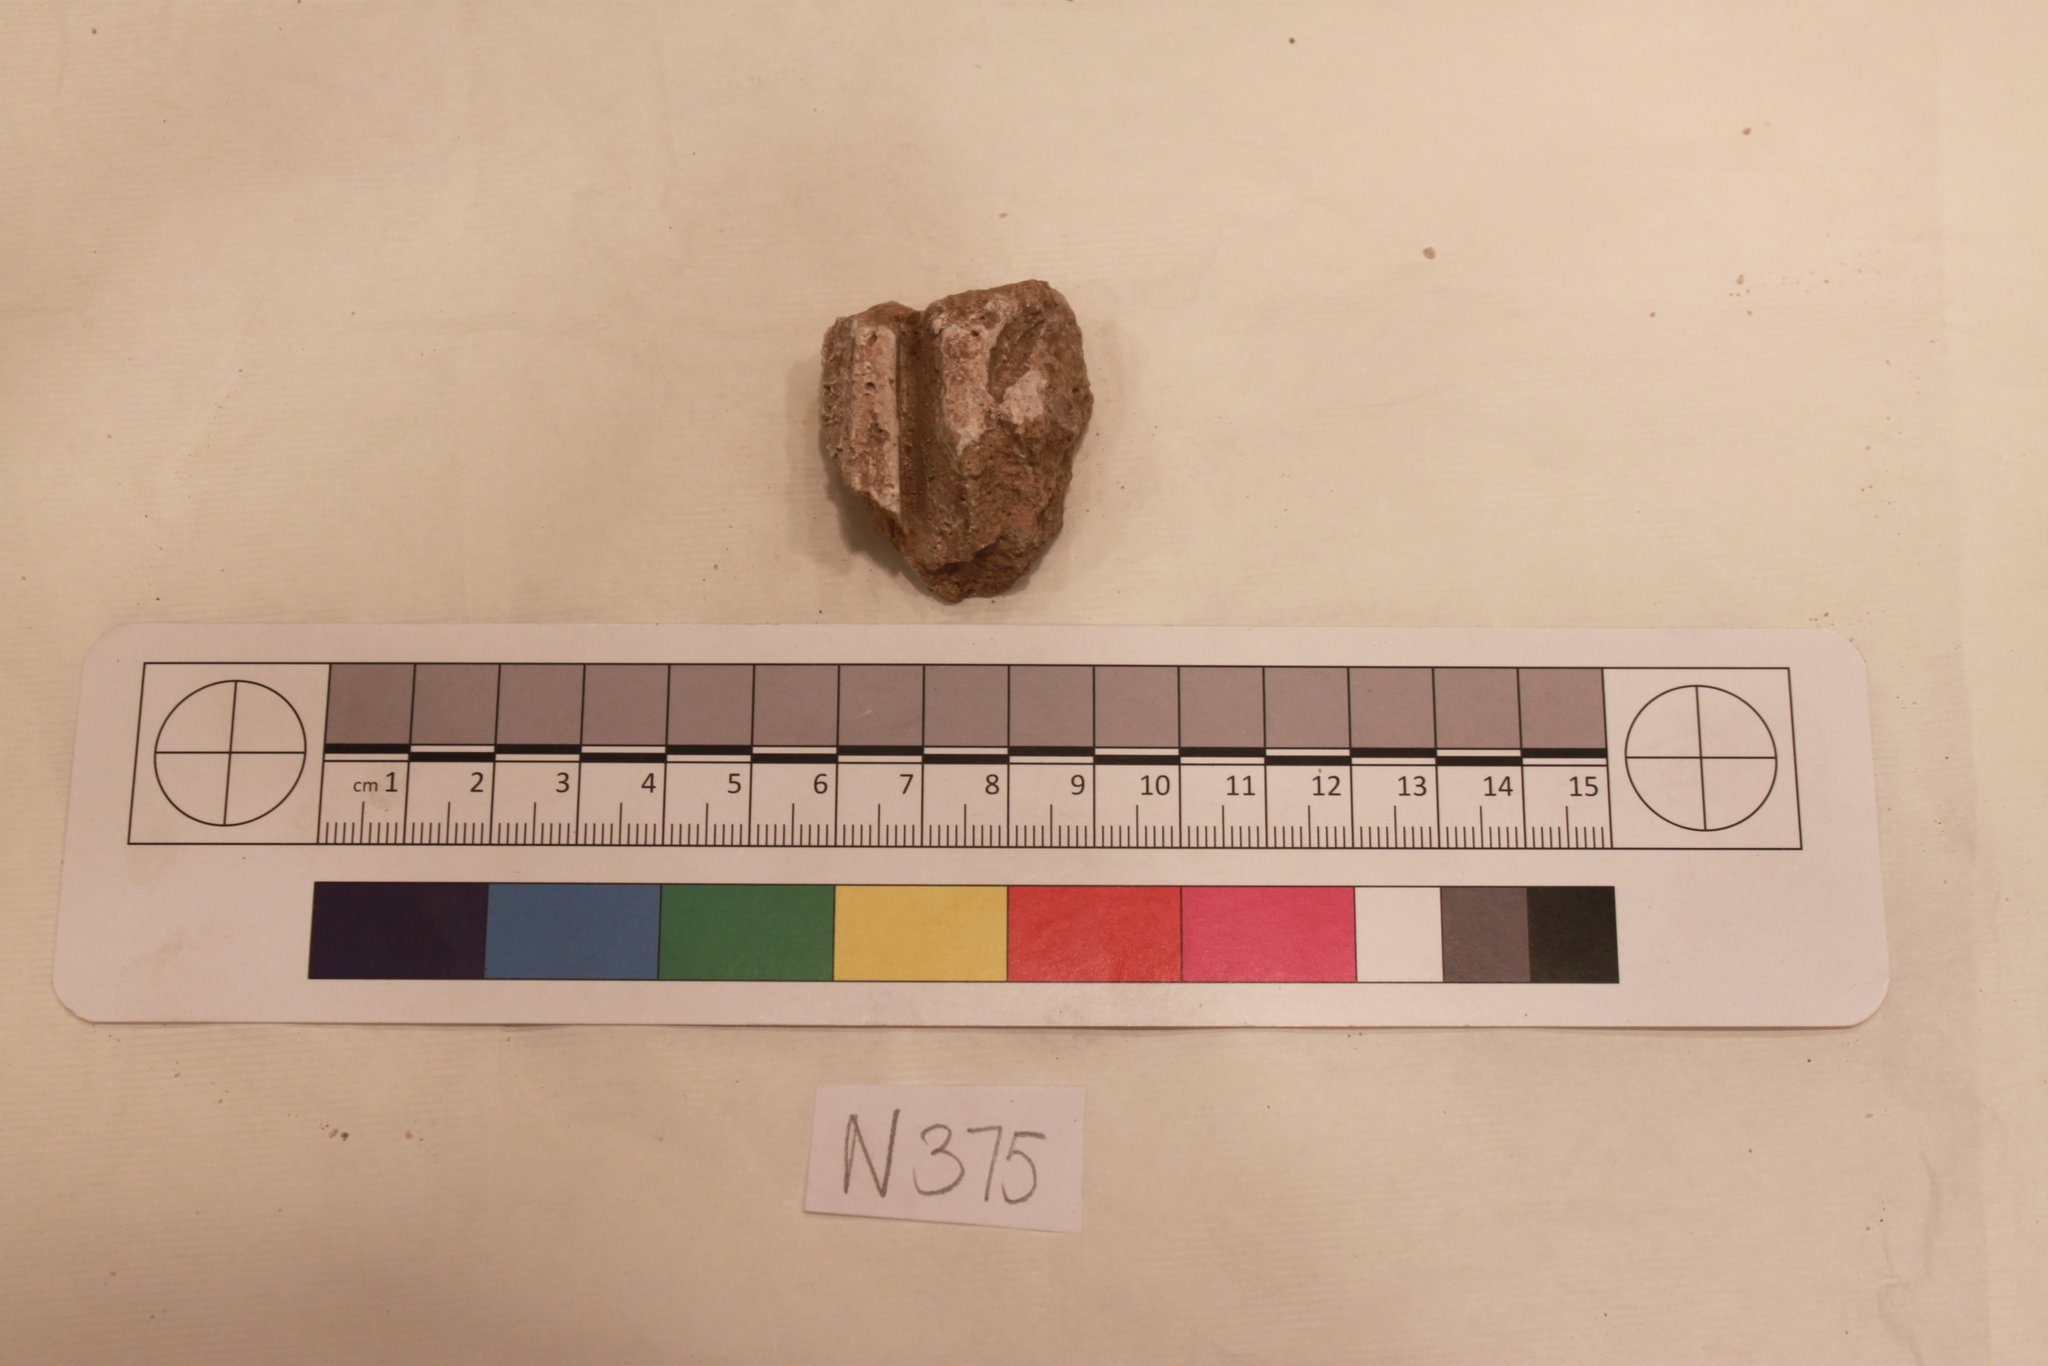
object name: fragment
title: Stucco Fragment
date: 701-1200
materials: plaster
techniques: carving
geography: iran